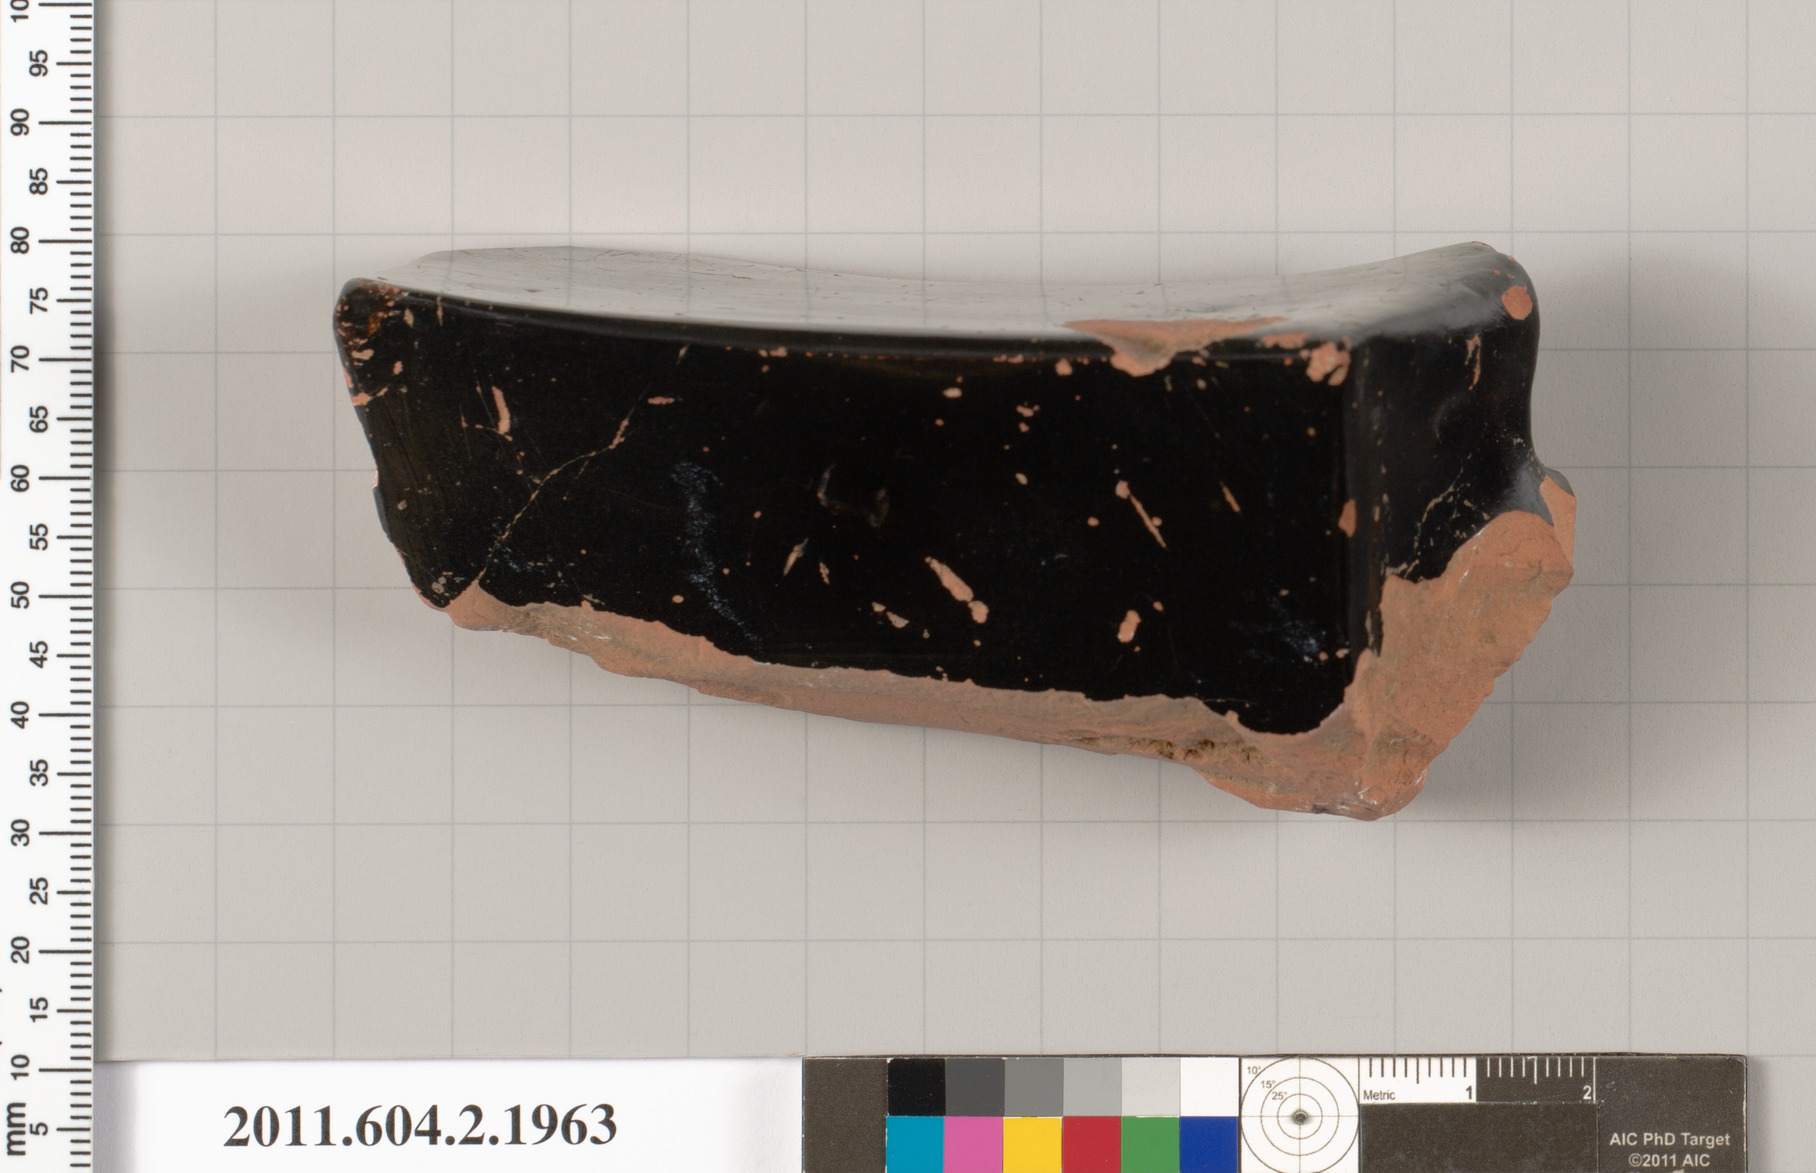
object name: bell krater fragment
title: Terracotta fragment of a bell-krater (bowl for mixing wine and water)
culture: greek, attic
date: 475-451 BCE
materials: terracotta